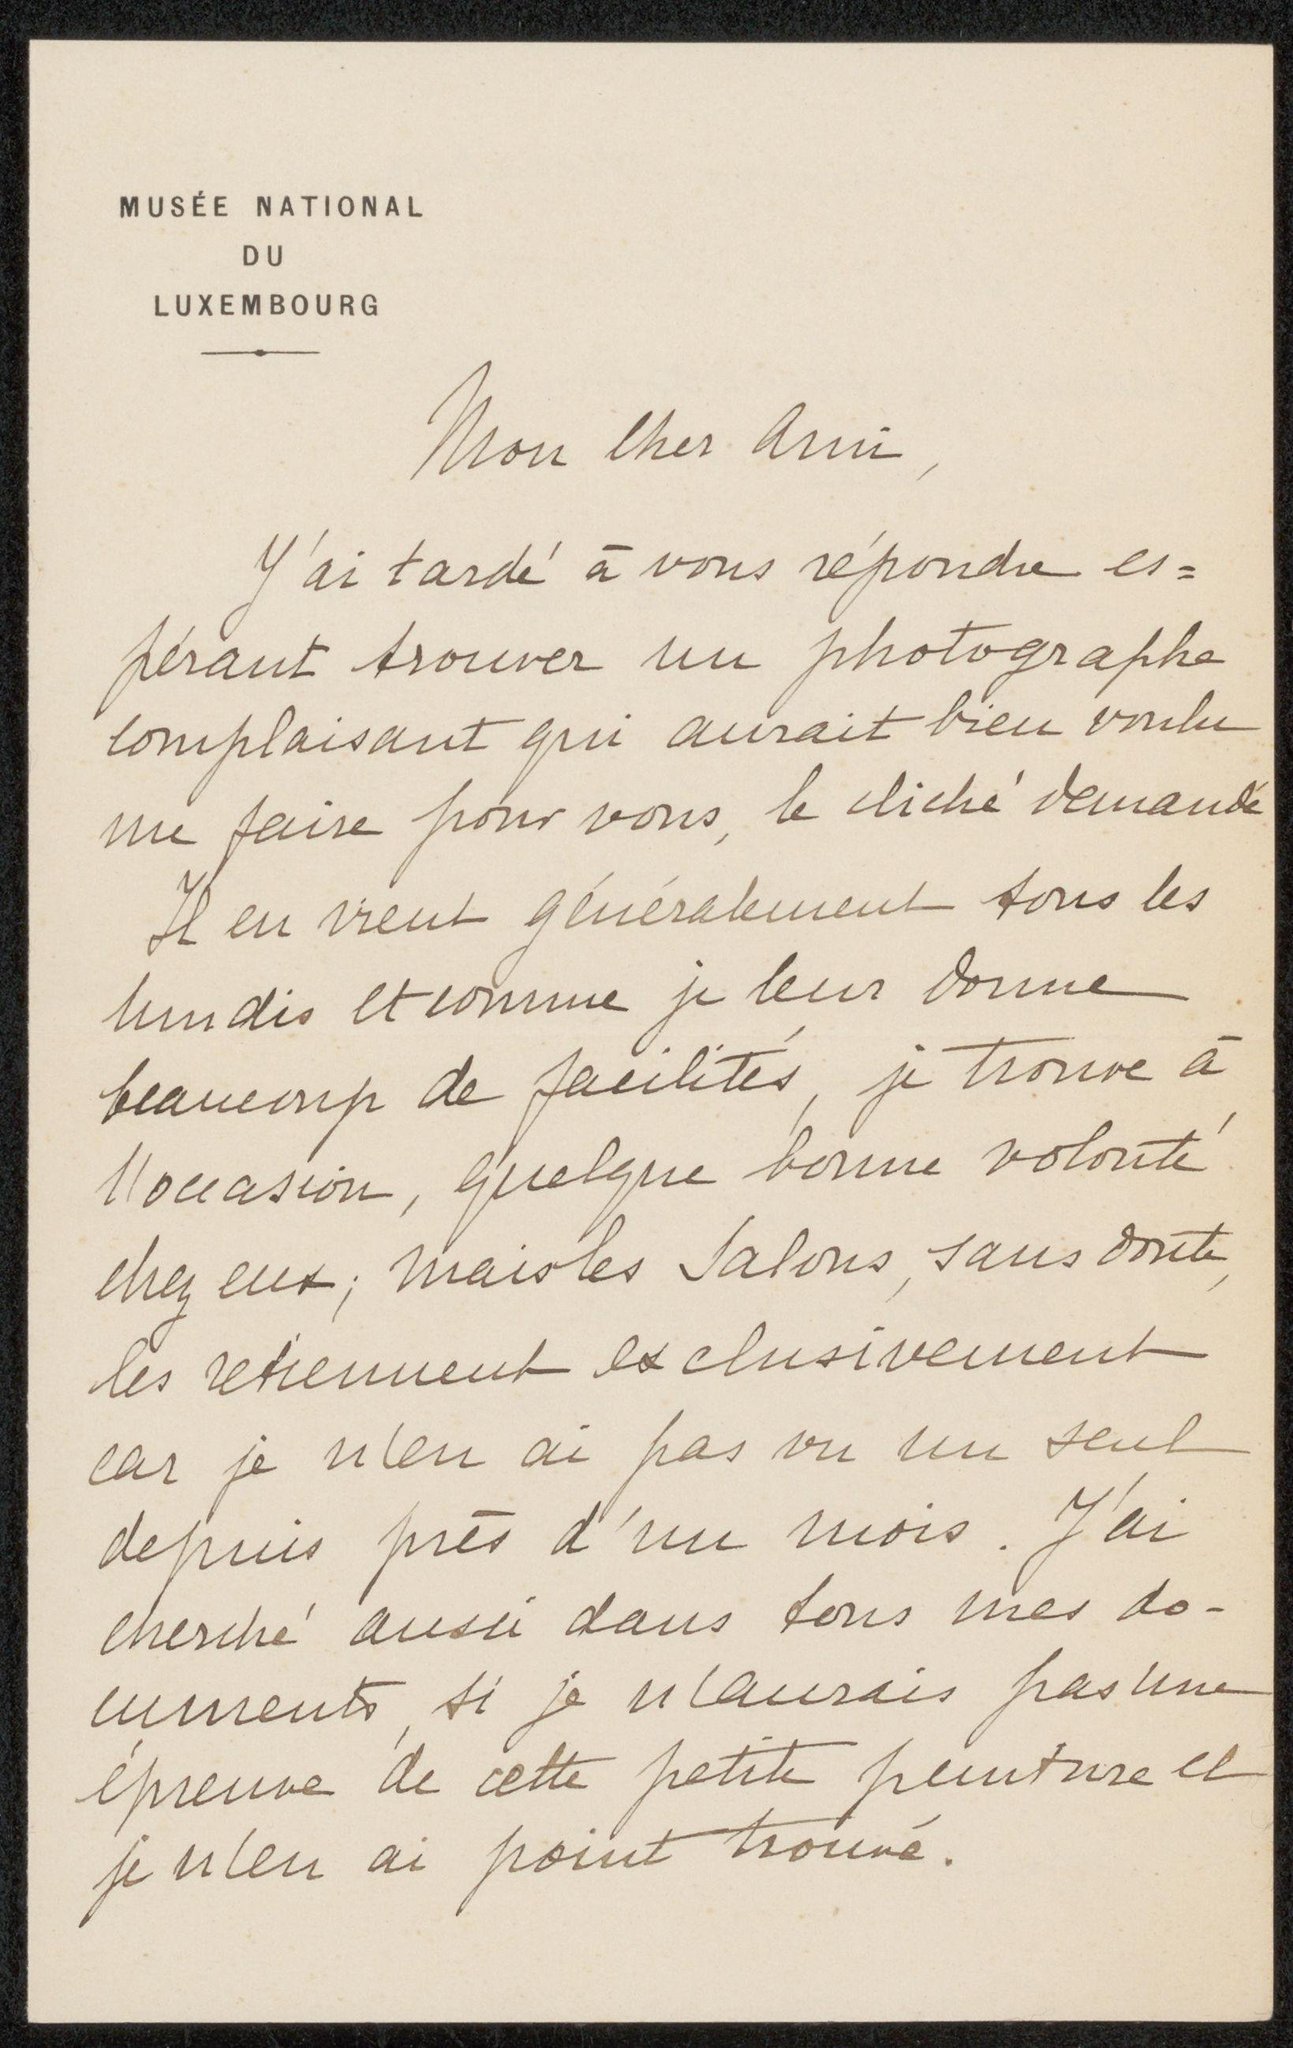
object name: letter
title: Brief aan Philip Zilcken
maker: léonce bénédite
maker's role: conservator, museumdirecteur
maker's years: 1856-1925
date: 1914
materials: ink, paper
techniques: pen, printing, writing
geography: paris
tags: the hague, draughtsman, philip zilcken, photography, cinematography, painting (including book-illumination, miniature-painting)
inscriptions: collector's mark: ‘RPK’